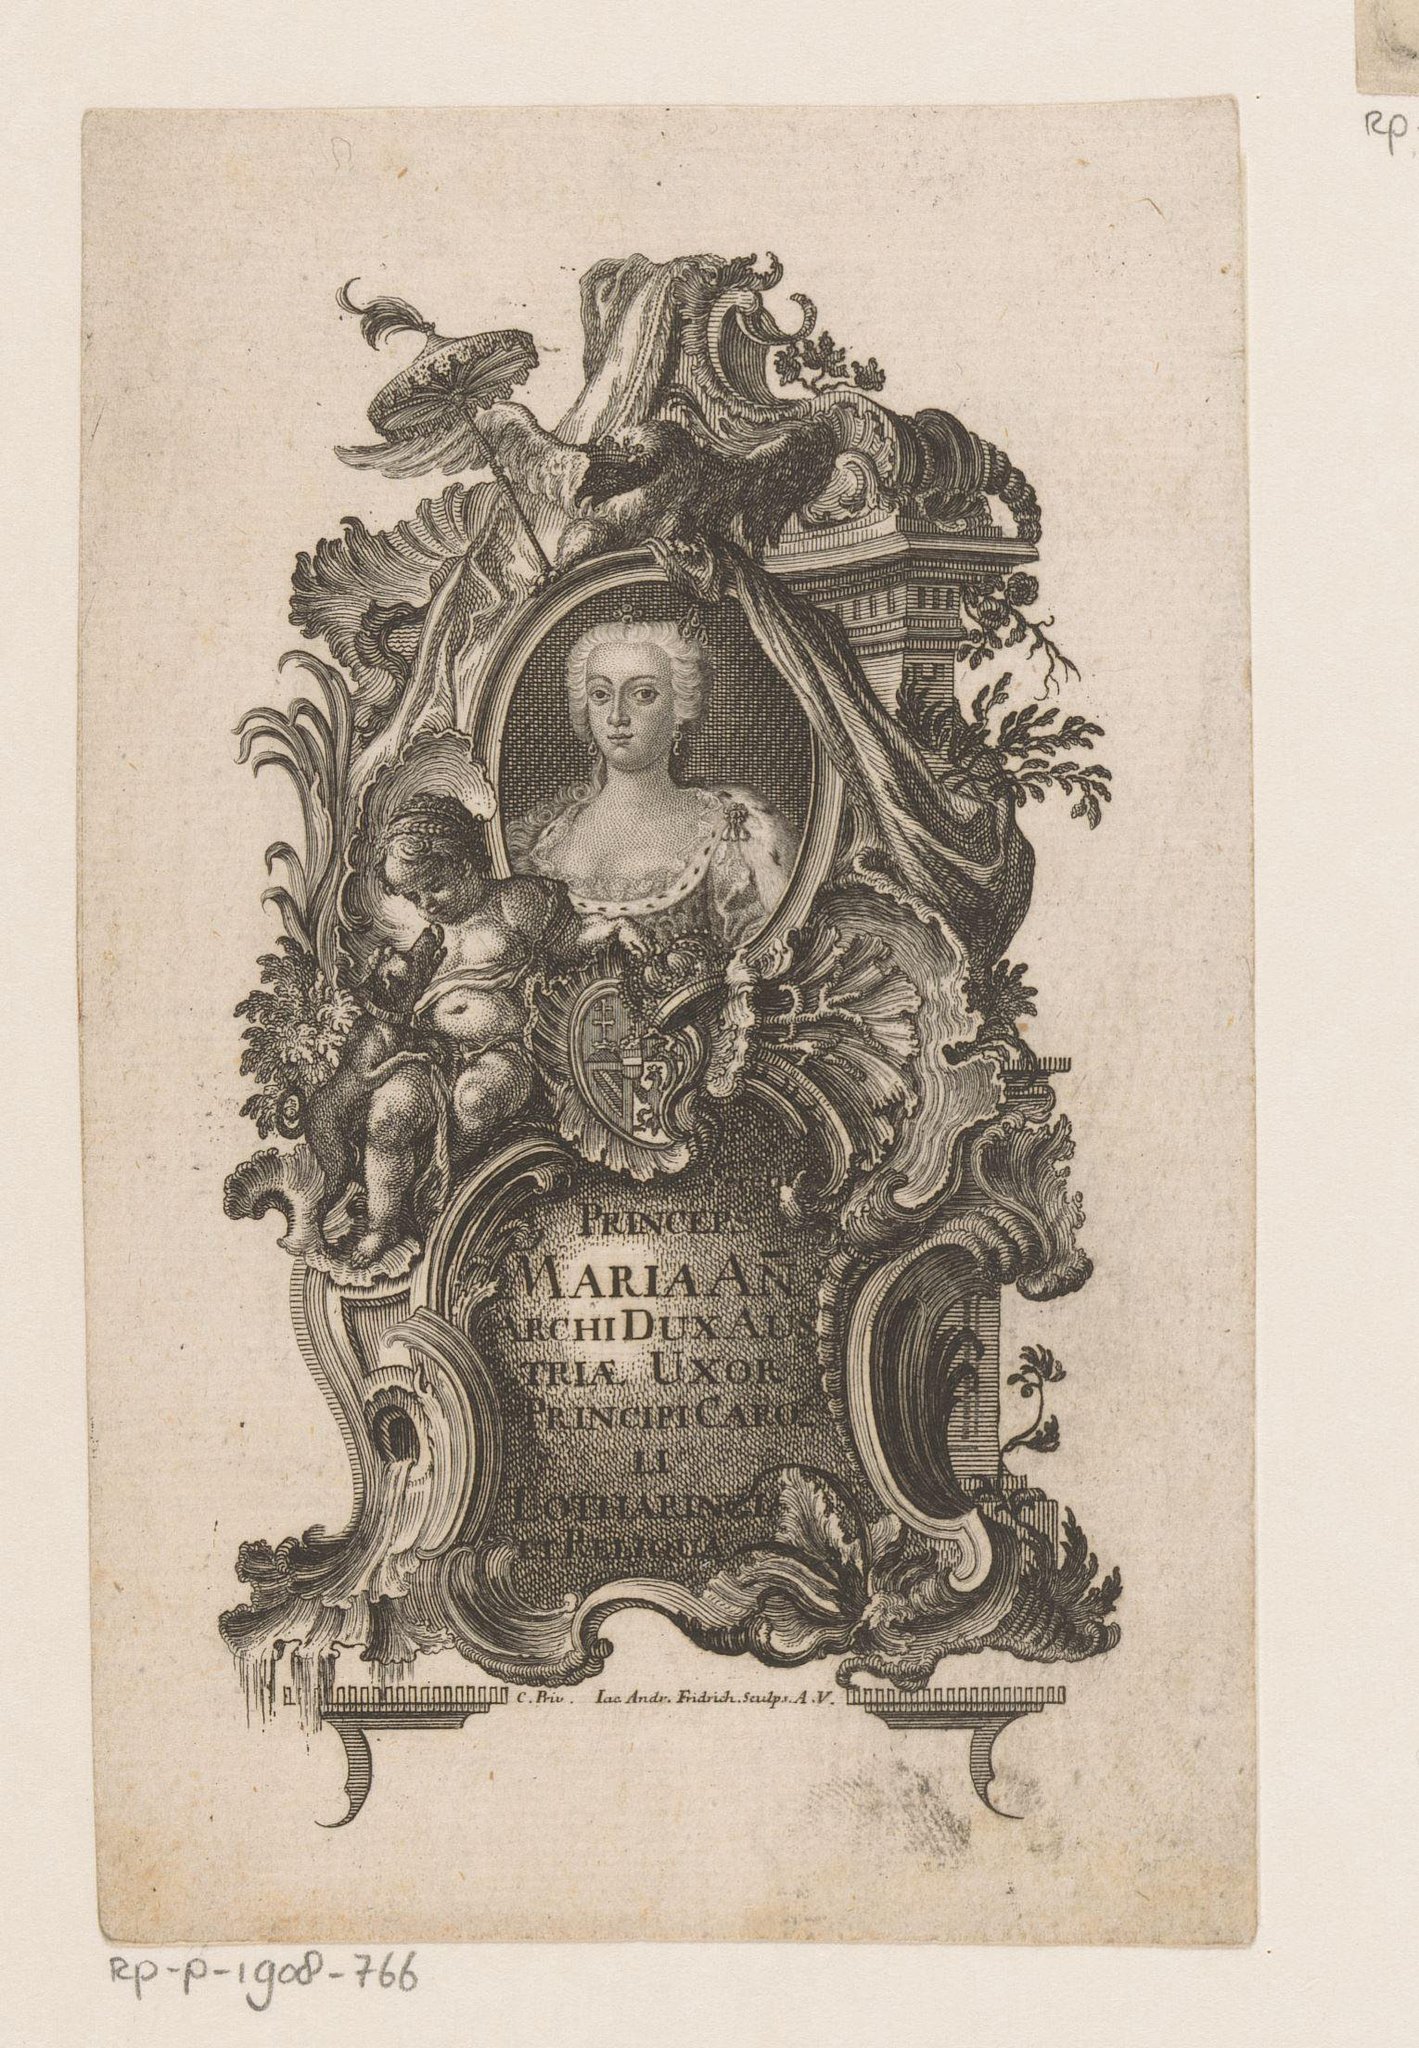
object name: print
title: Portret van Maria Anna van Oostenrijk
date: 1748-1779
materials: paper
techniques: engraving, etching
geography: holy roman empire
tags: vienna, rocaille ornament, historical persons - bb - woman, ornament ~ medallion, armorial bearing, heraldry, insignia and symbols of sovereignty (crown, diadem, sceptre, orb, seal, standard, cloak, pectoral)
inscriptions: collector's mark: Lugt 2228